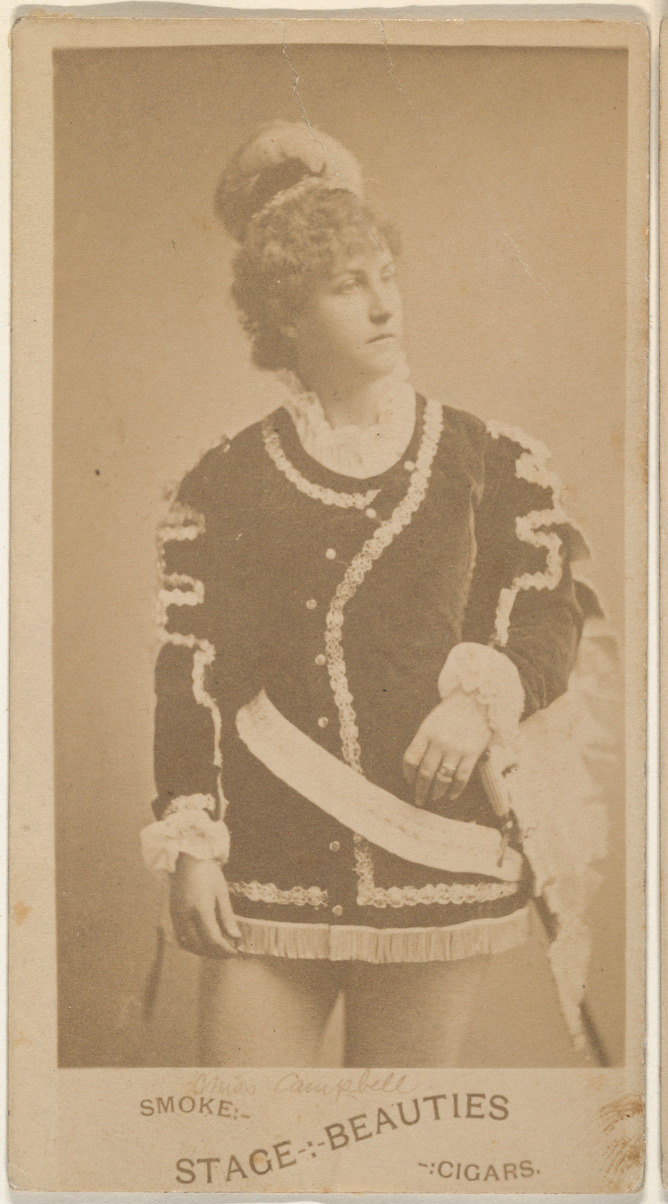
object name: photograph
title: Miss Campbell, from the Actresses series (N666) to promote Stage Beauties Cigars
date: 1888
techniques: albumen silver print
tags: portraits,women,actresses